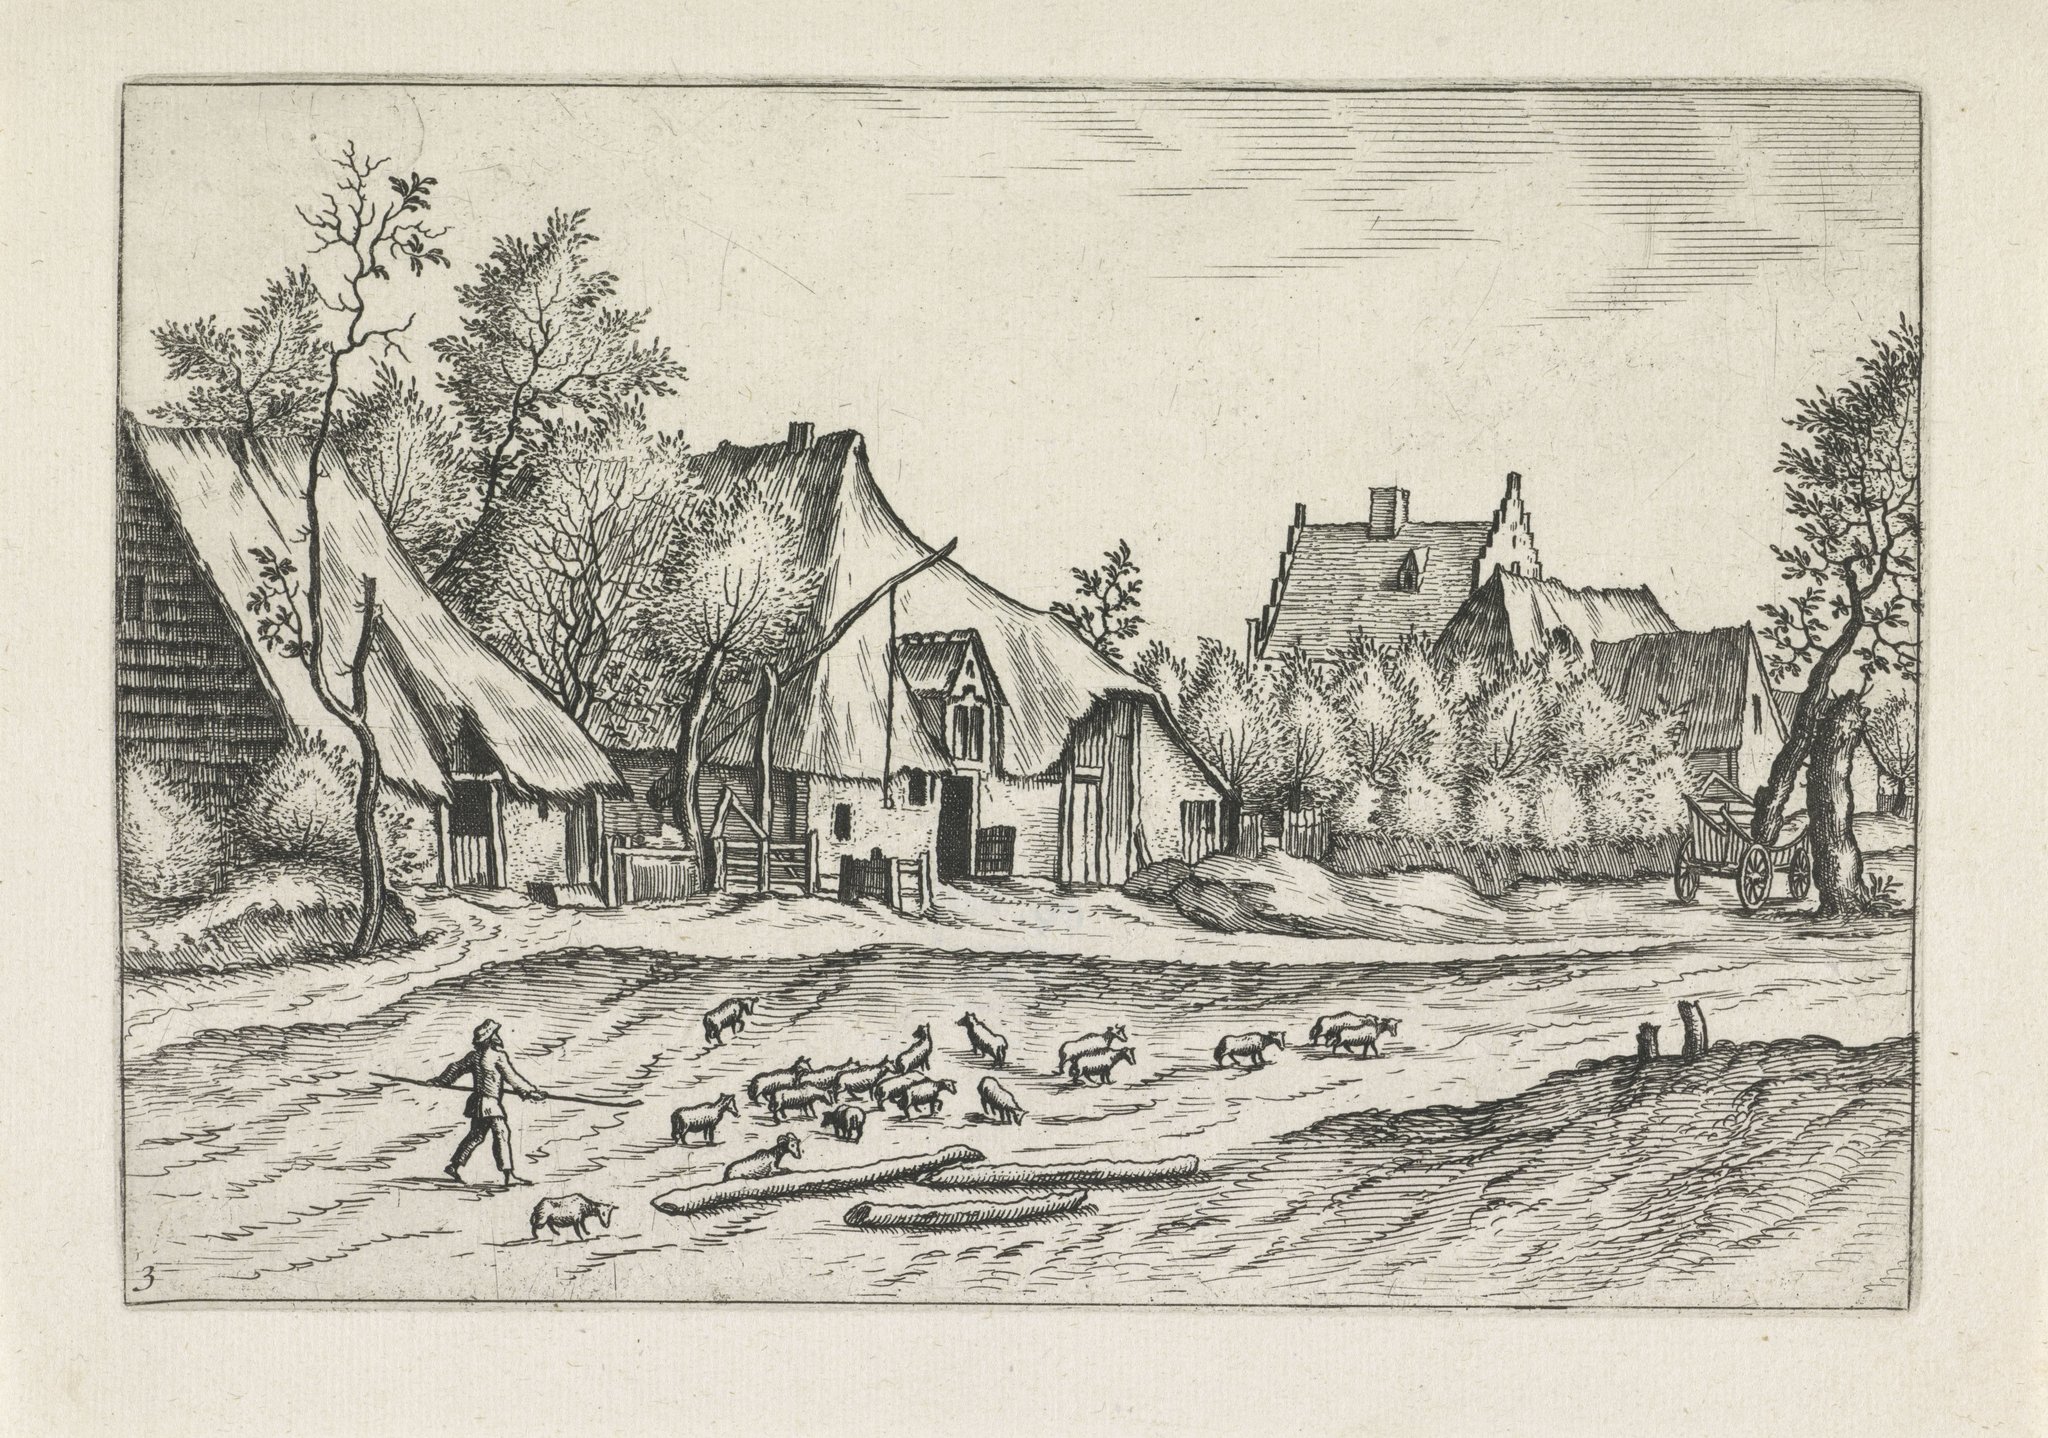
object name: print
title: Dorpsweg met kudde schapen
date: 1559-1561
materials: paper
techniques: etching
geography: antwerp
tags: sheep, public road in village, farm (building)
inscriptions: collector's mark: Lugt 2228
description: Boerderijen langs een weg. Op de voorgrond een herder met een kudde schapen.